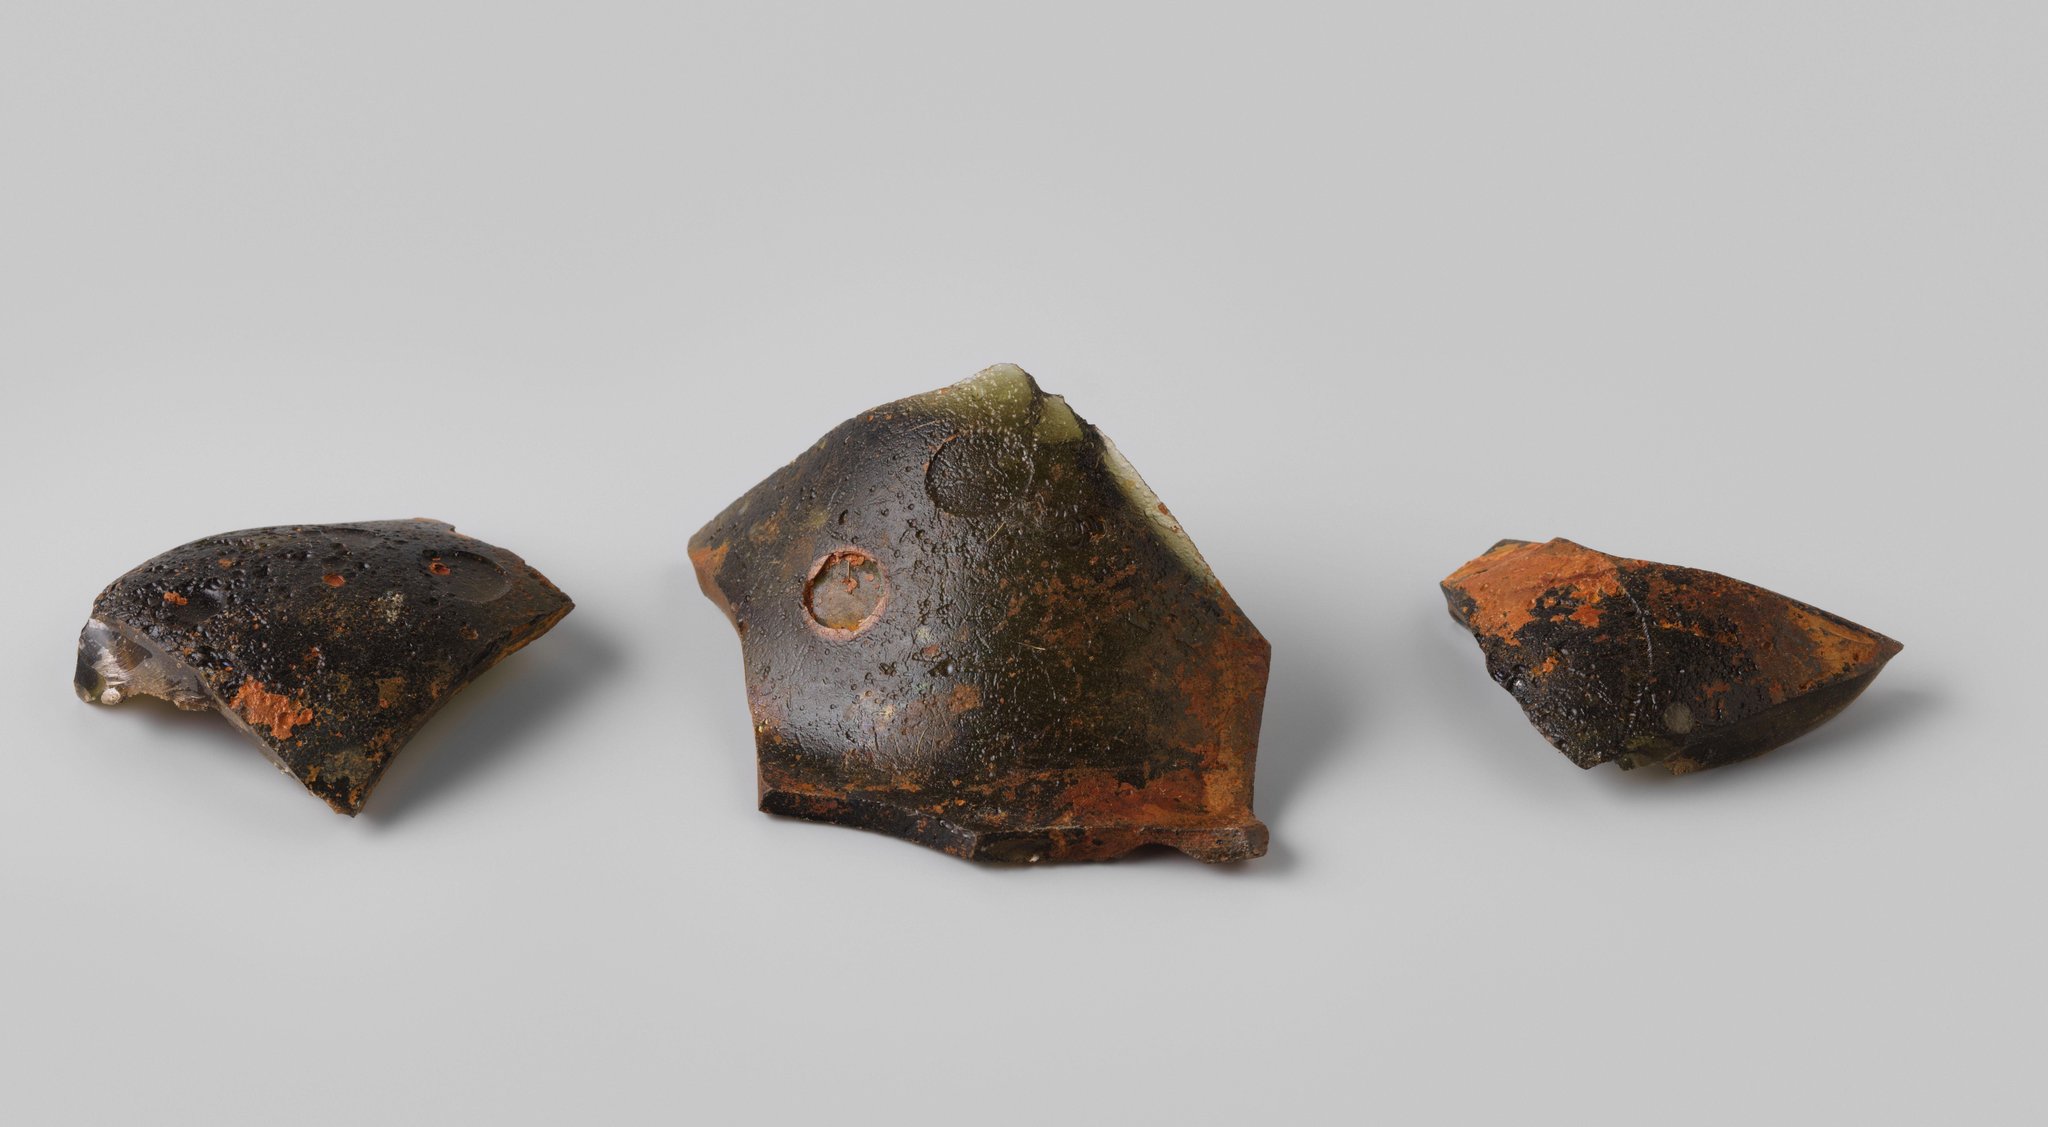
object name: sherd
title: Scherven van wijnflessen uit het wrak van de Oost-Indiëvaarder Hollandia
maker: Anonymous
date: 1700-1743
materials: glass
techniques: green glass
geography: netherlands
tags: verenigde oostindische compagnie, hollandia (schip), annet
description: Onion-shaped bottle or bottle with vertical side, base, fragm, cs-kick-up. Continental production.